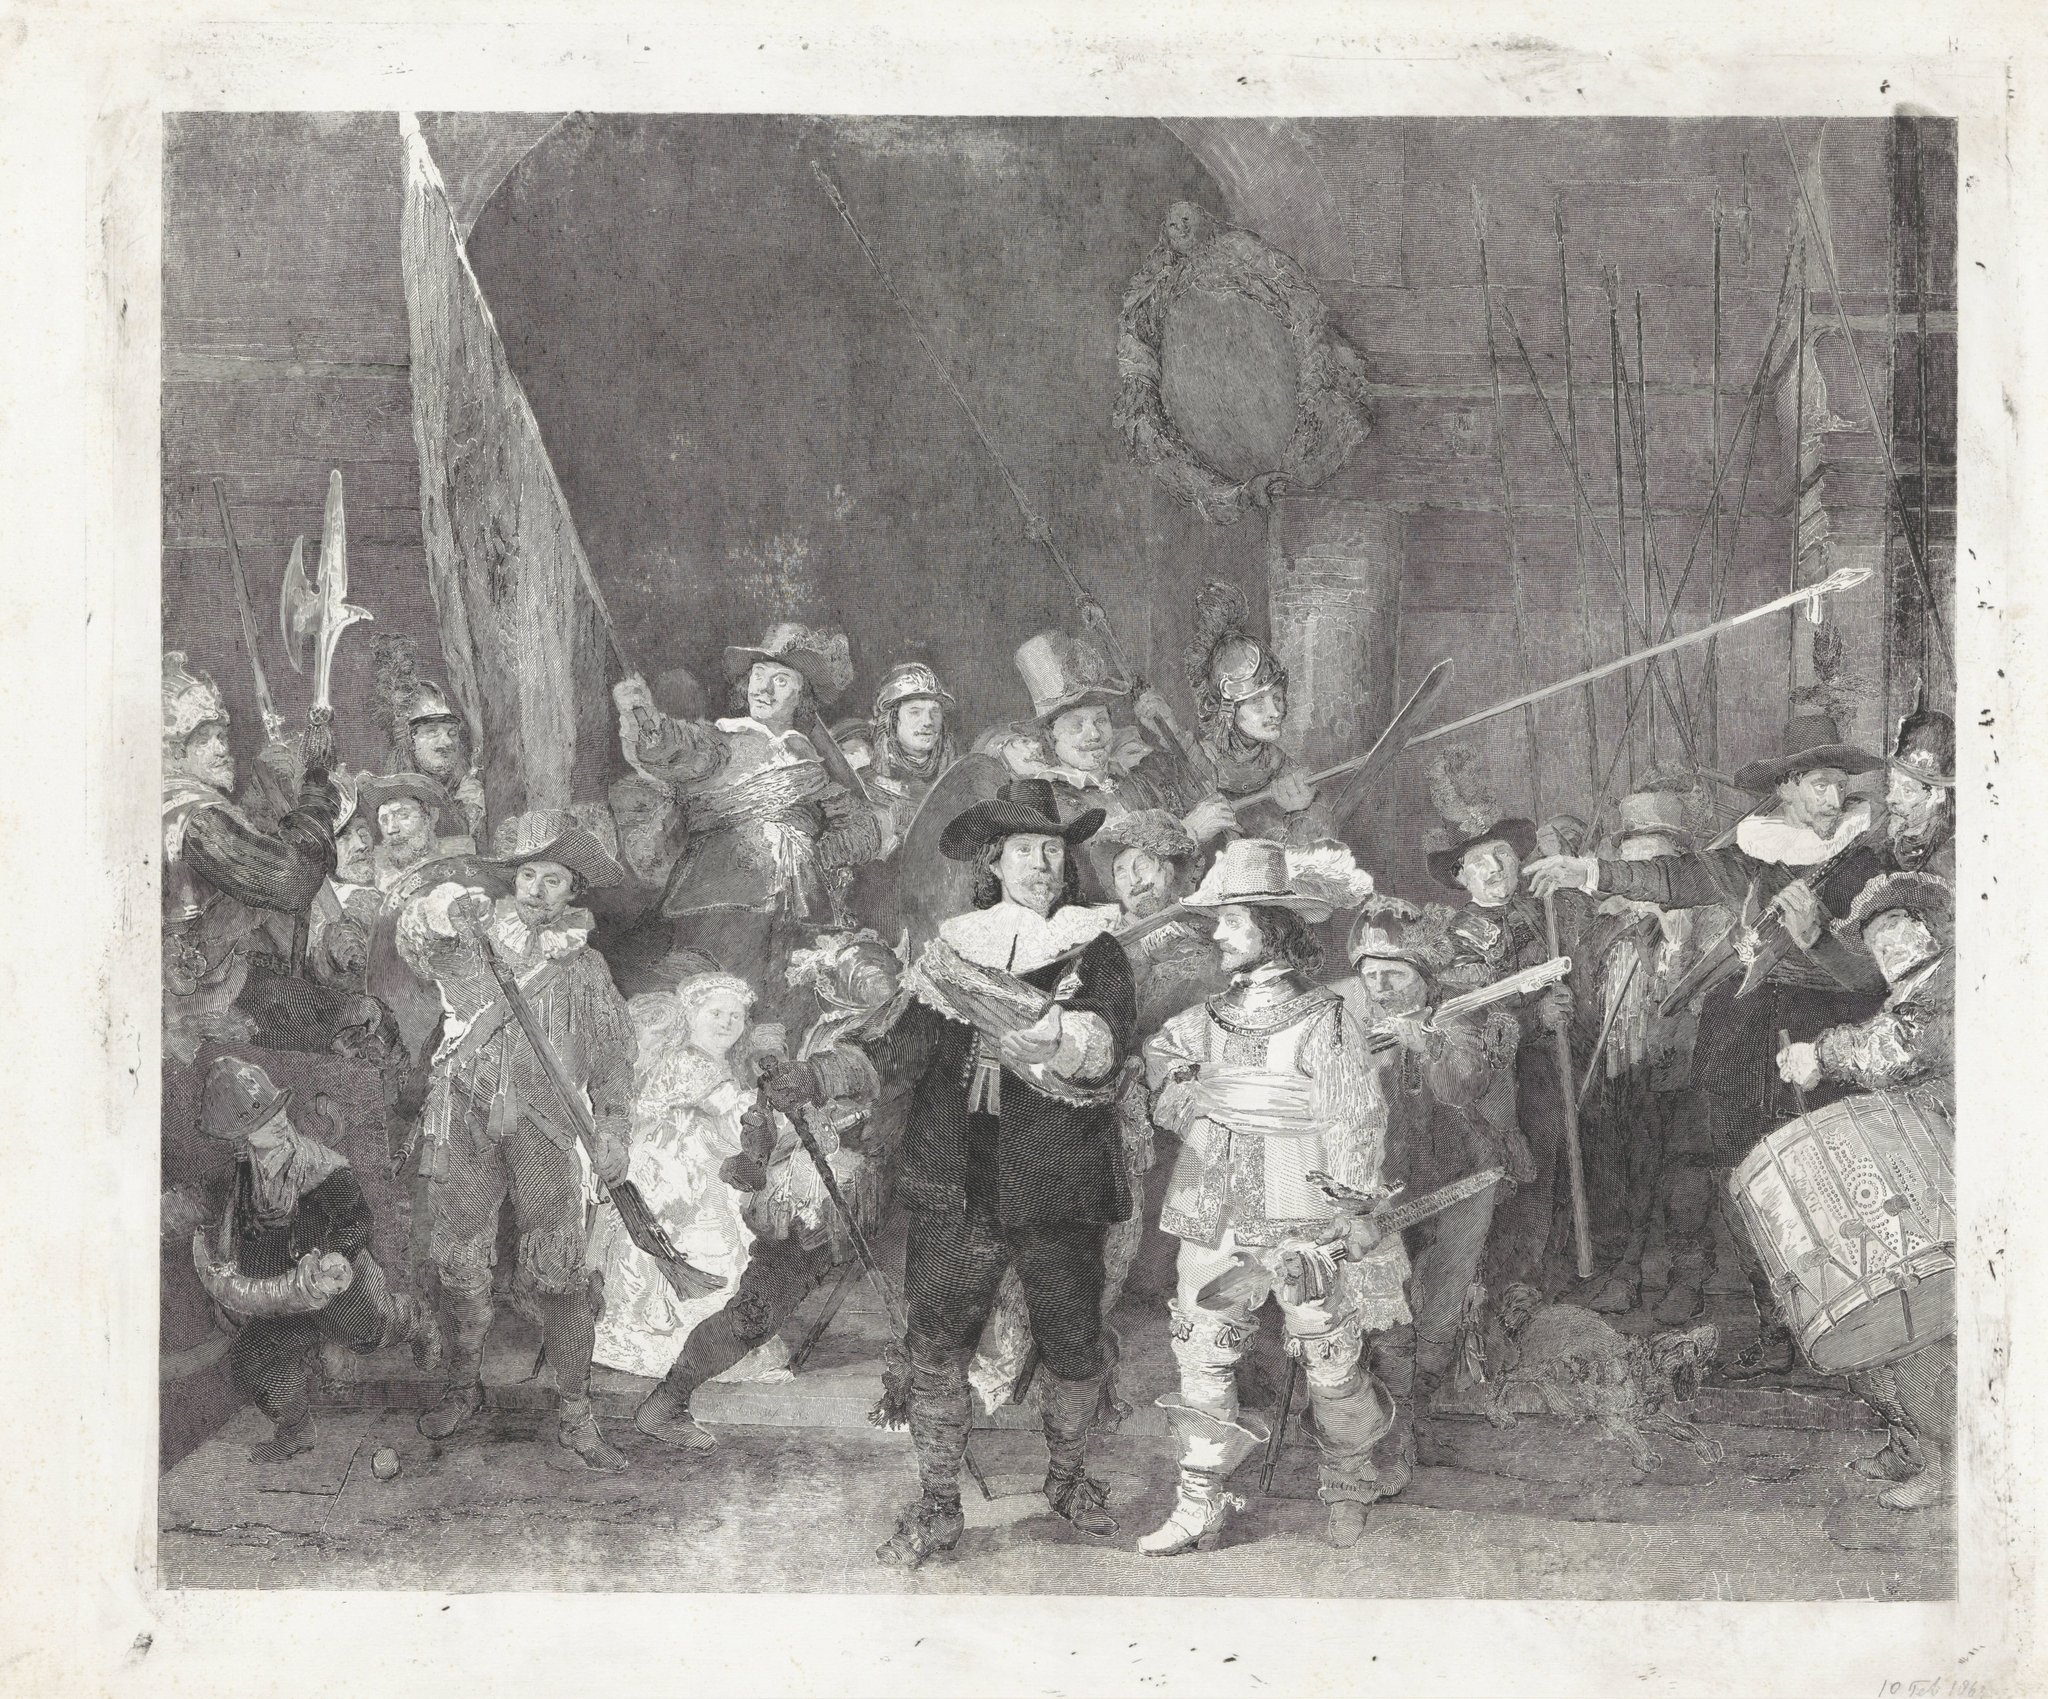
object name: print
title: Het korporaalschap van kapitein Frans Banninck Cocq en luitenant Willem van Ruytenburch, bekend als de 'Nachtwacht'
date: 1863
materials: paper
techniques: drypoint, engraving, etching, roulette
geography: amsterdam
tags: proclamation of peace, celebration meal, feast, banquet, festivities on events of national importance, picture, painting, land forces (+ citizen soldiery, civil guard, citizen militia), historical events and situations, dog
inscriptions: inscription: ‘10 Feb 1863’, collector's mark: Lugt 2228